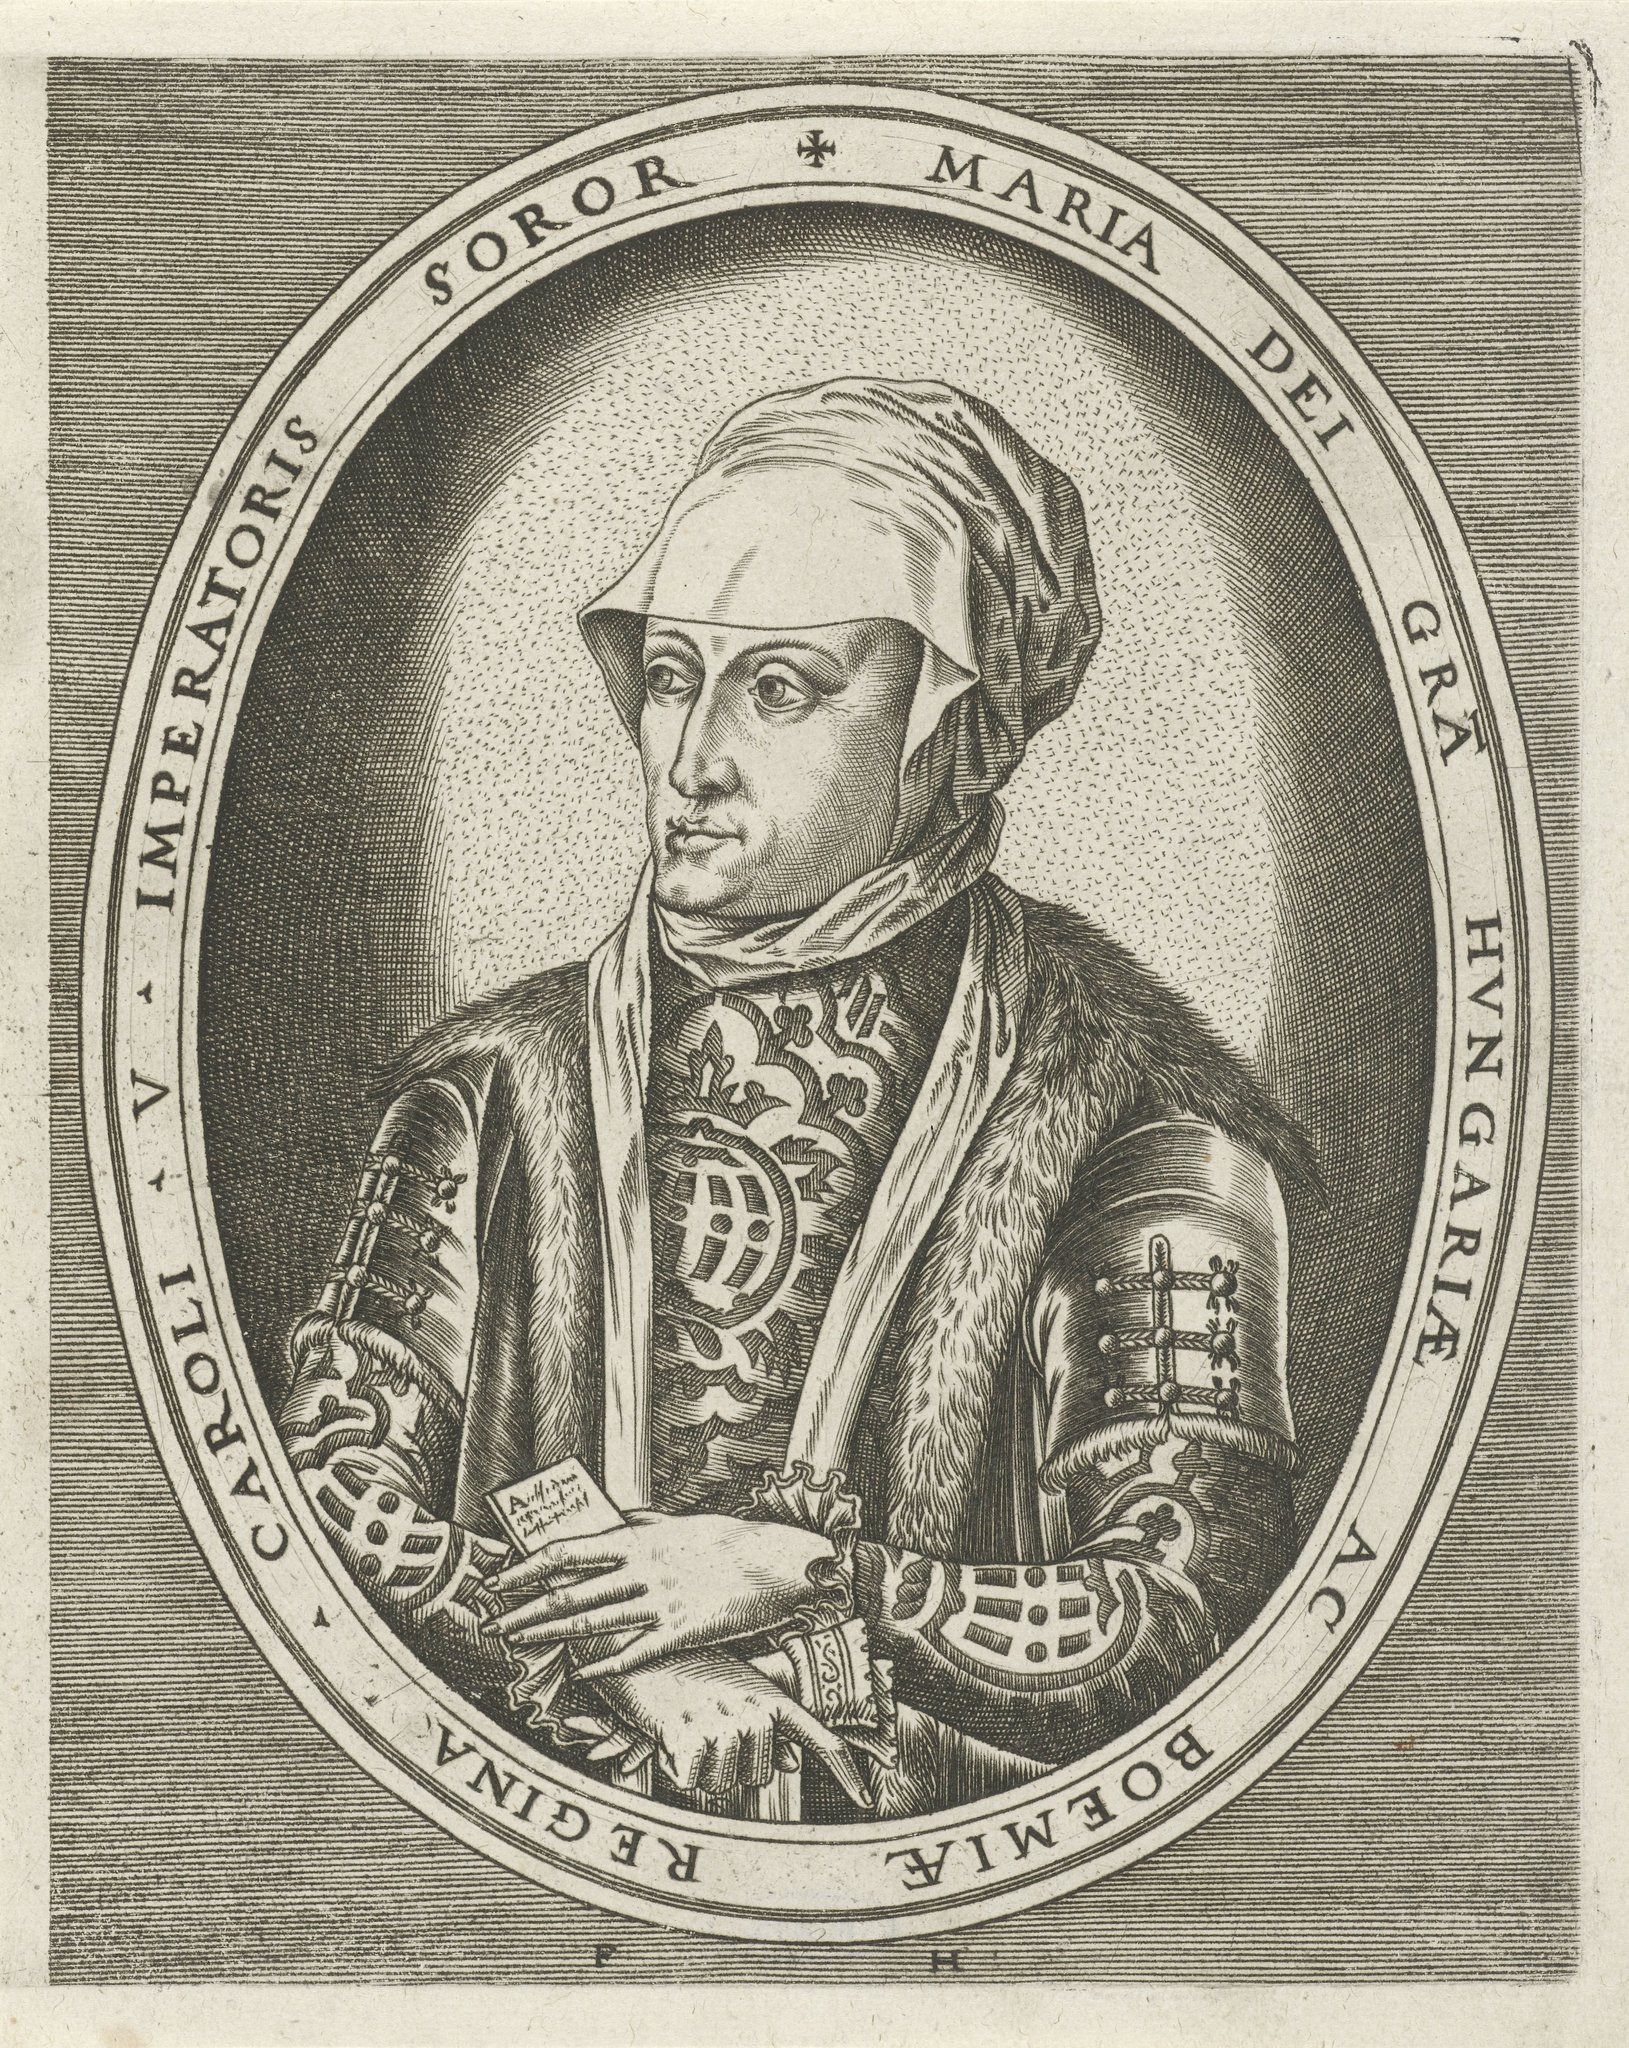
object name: print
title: Portretten van koningen, koninginnen, prinsen en prinsessen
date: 1546-1562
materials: paper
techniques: engraving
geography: antwerp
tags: brussels, maria van hongarije (landvoogdes der nederlanden)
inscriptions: collector's mark: Lugt 2228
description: Portret van Maria van Hongarije, landvoogdes der Nederlanden, ten halven lijve naar links met een papier met opschrift in haar hand, in een ovale lijst met randschrift in het Latijn.